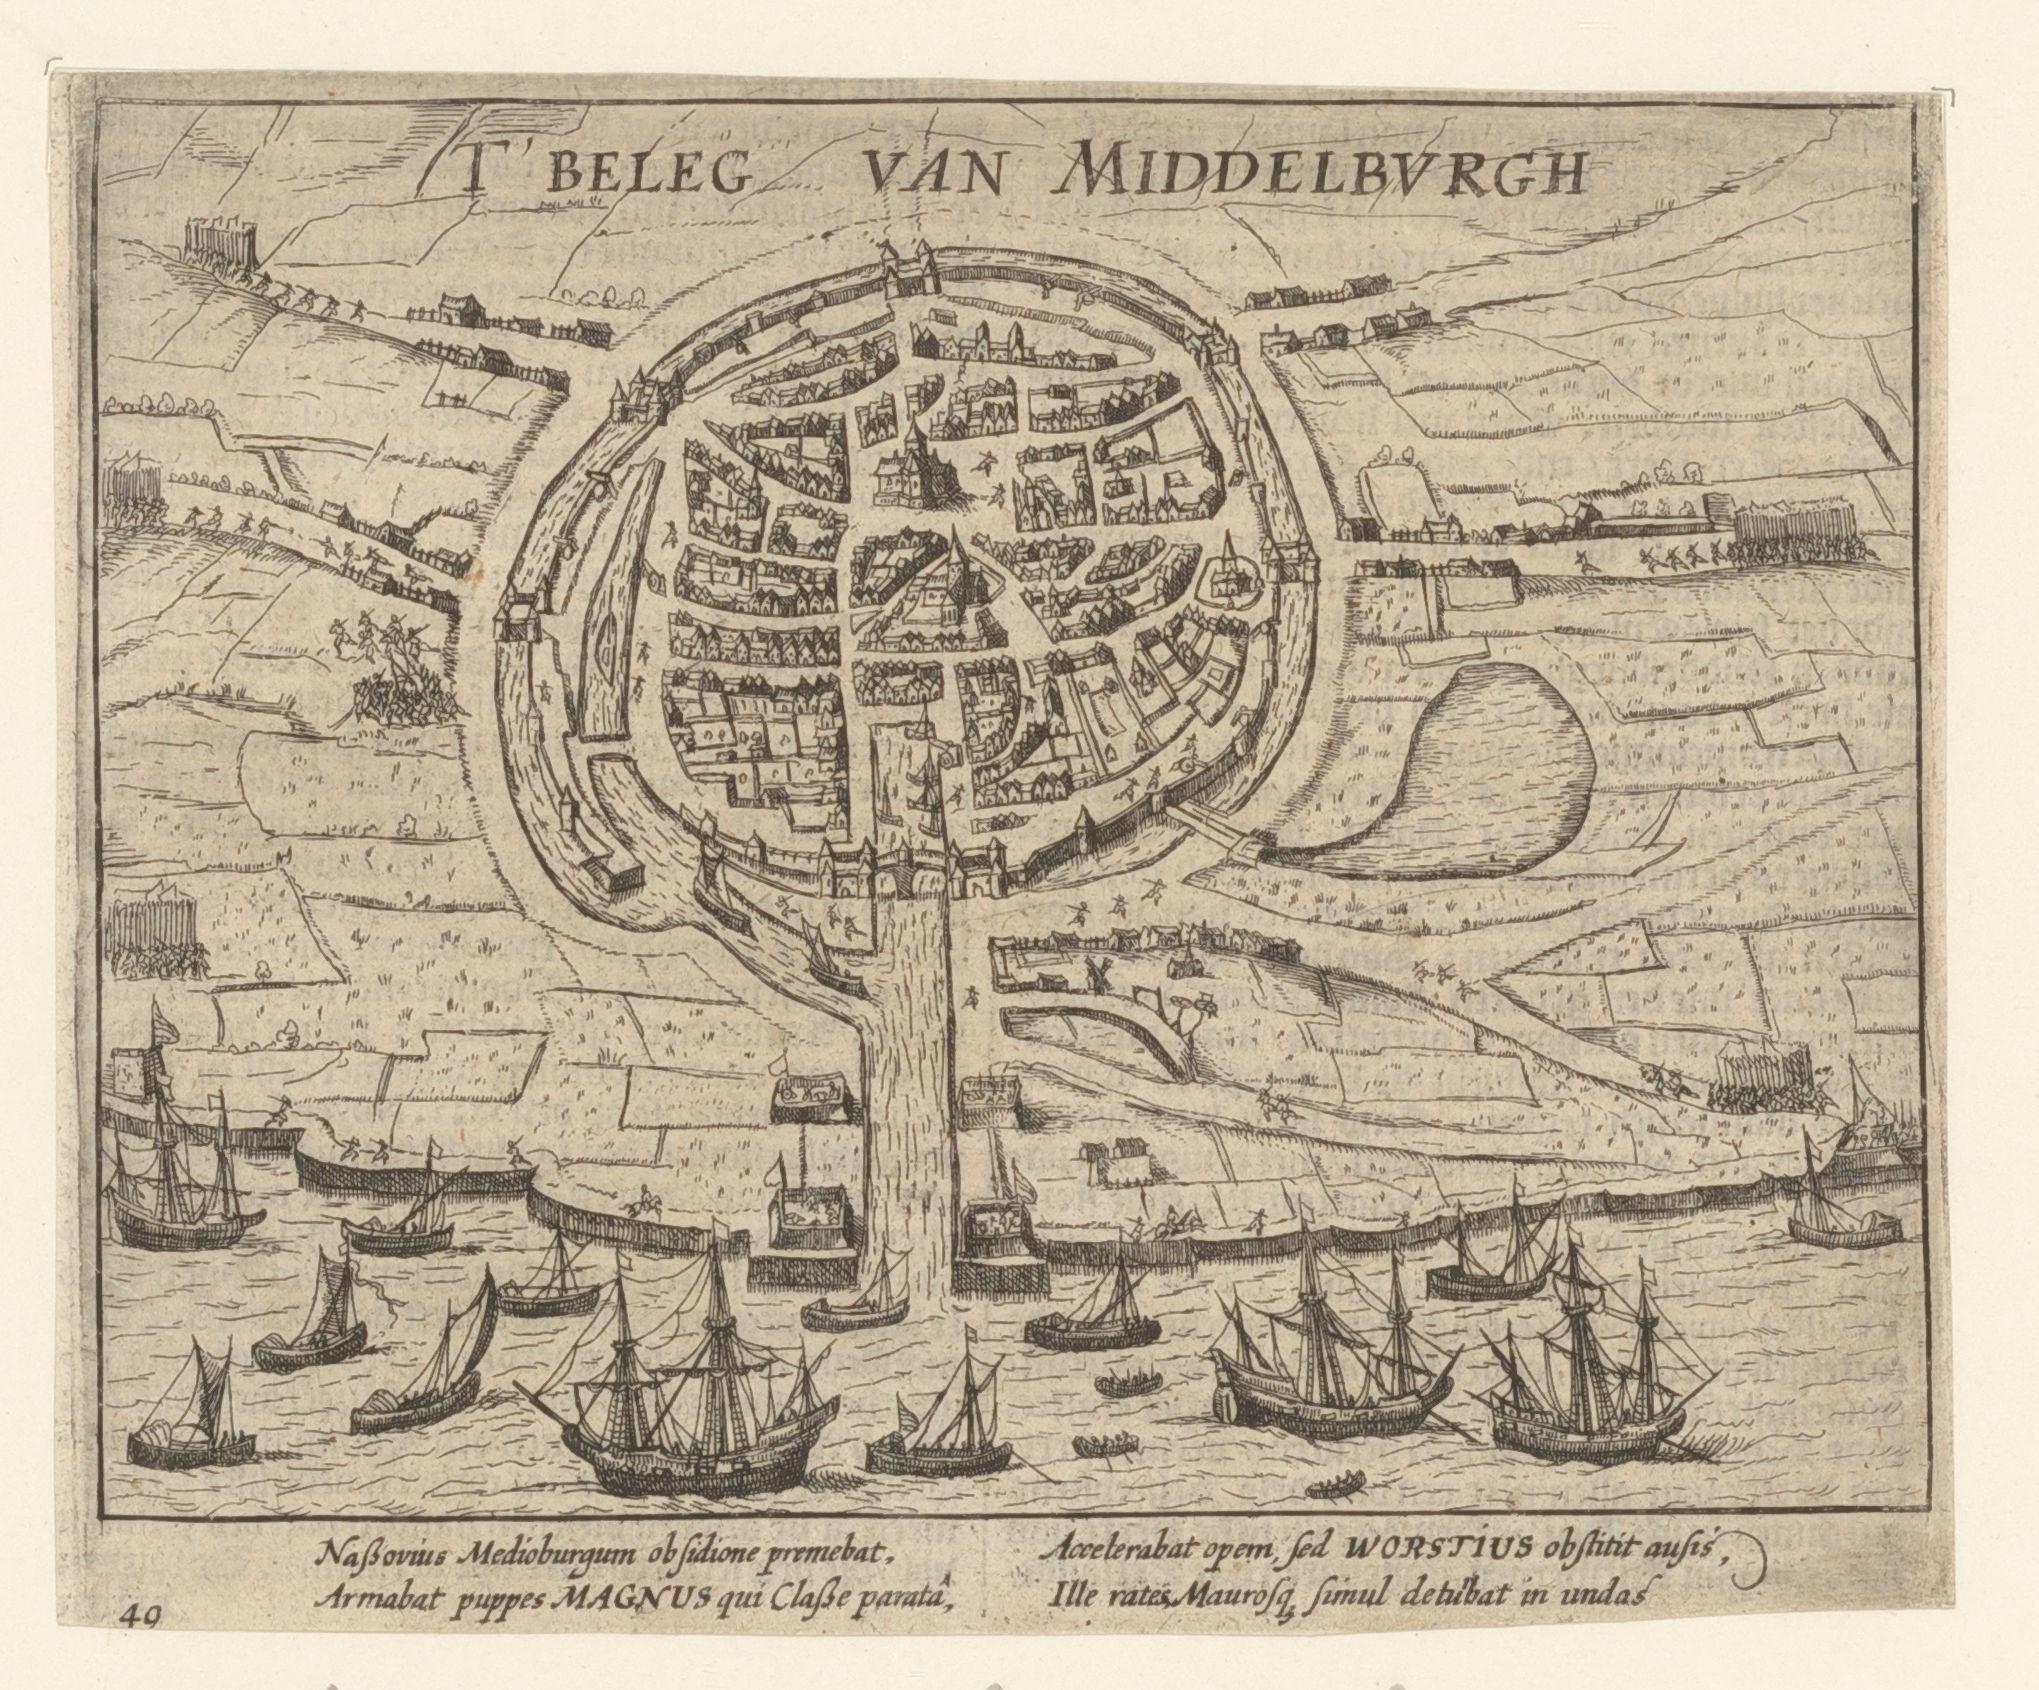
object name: book illustration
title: T Beleg van Middelburgh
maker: Anonymous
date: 1613-1615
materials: paper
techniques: etching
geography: northern netherlands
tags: siege, position war, middelburg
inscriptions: collector's mark: Lugt 1641, collector's mark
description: Beleg van Middelburg door de opstandelingen, januari 1574. Gezicht op de belegerde stad en de omgeving. Op de voorgrond de schepen van de geuzen, uiterst links Fort Rammekens en rechts Arnemuiden. Met onderschrift van 4 regels in het Latijn. Genummerd: 49. Bedrukt op achterzijde met tekst in het Nederlands. Onderwerpsrubrieken binnen de Atlas Zeden en Gewoonten: Krijgswezen; prenten van Baudart. 80j. oorlog.